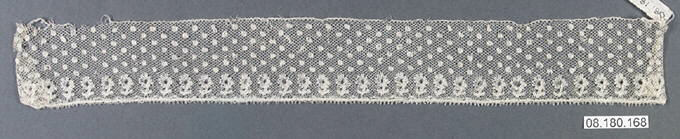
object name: fragment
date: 1801-1900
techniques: lace